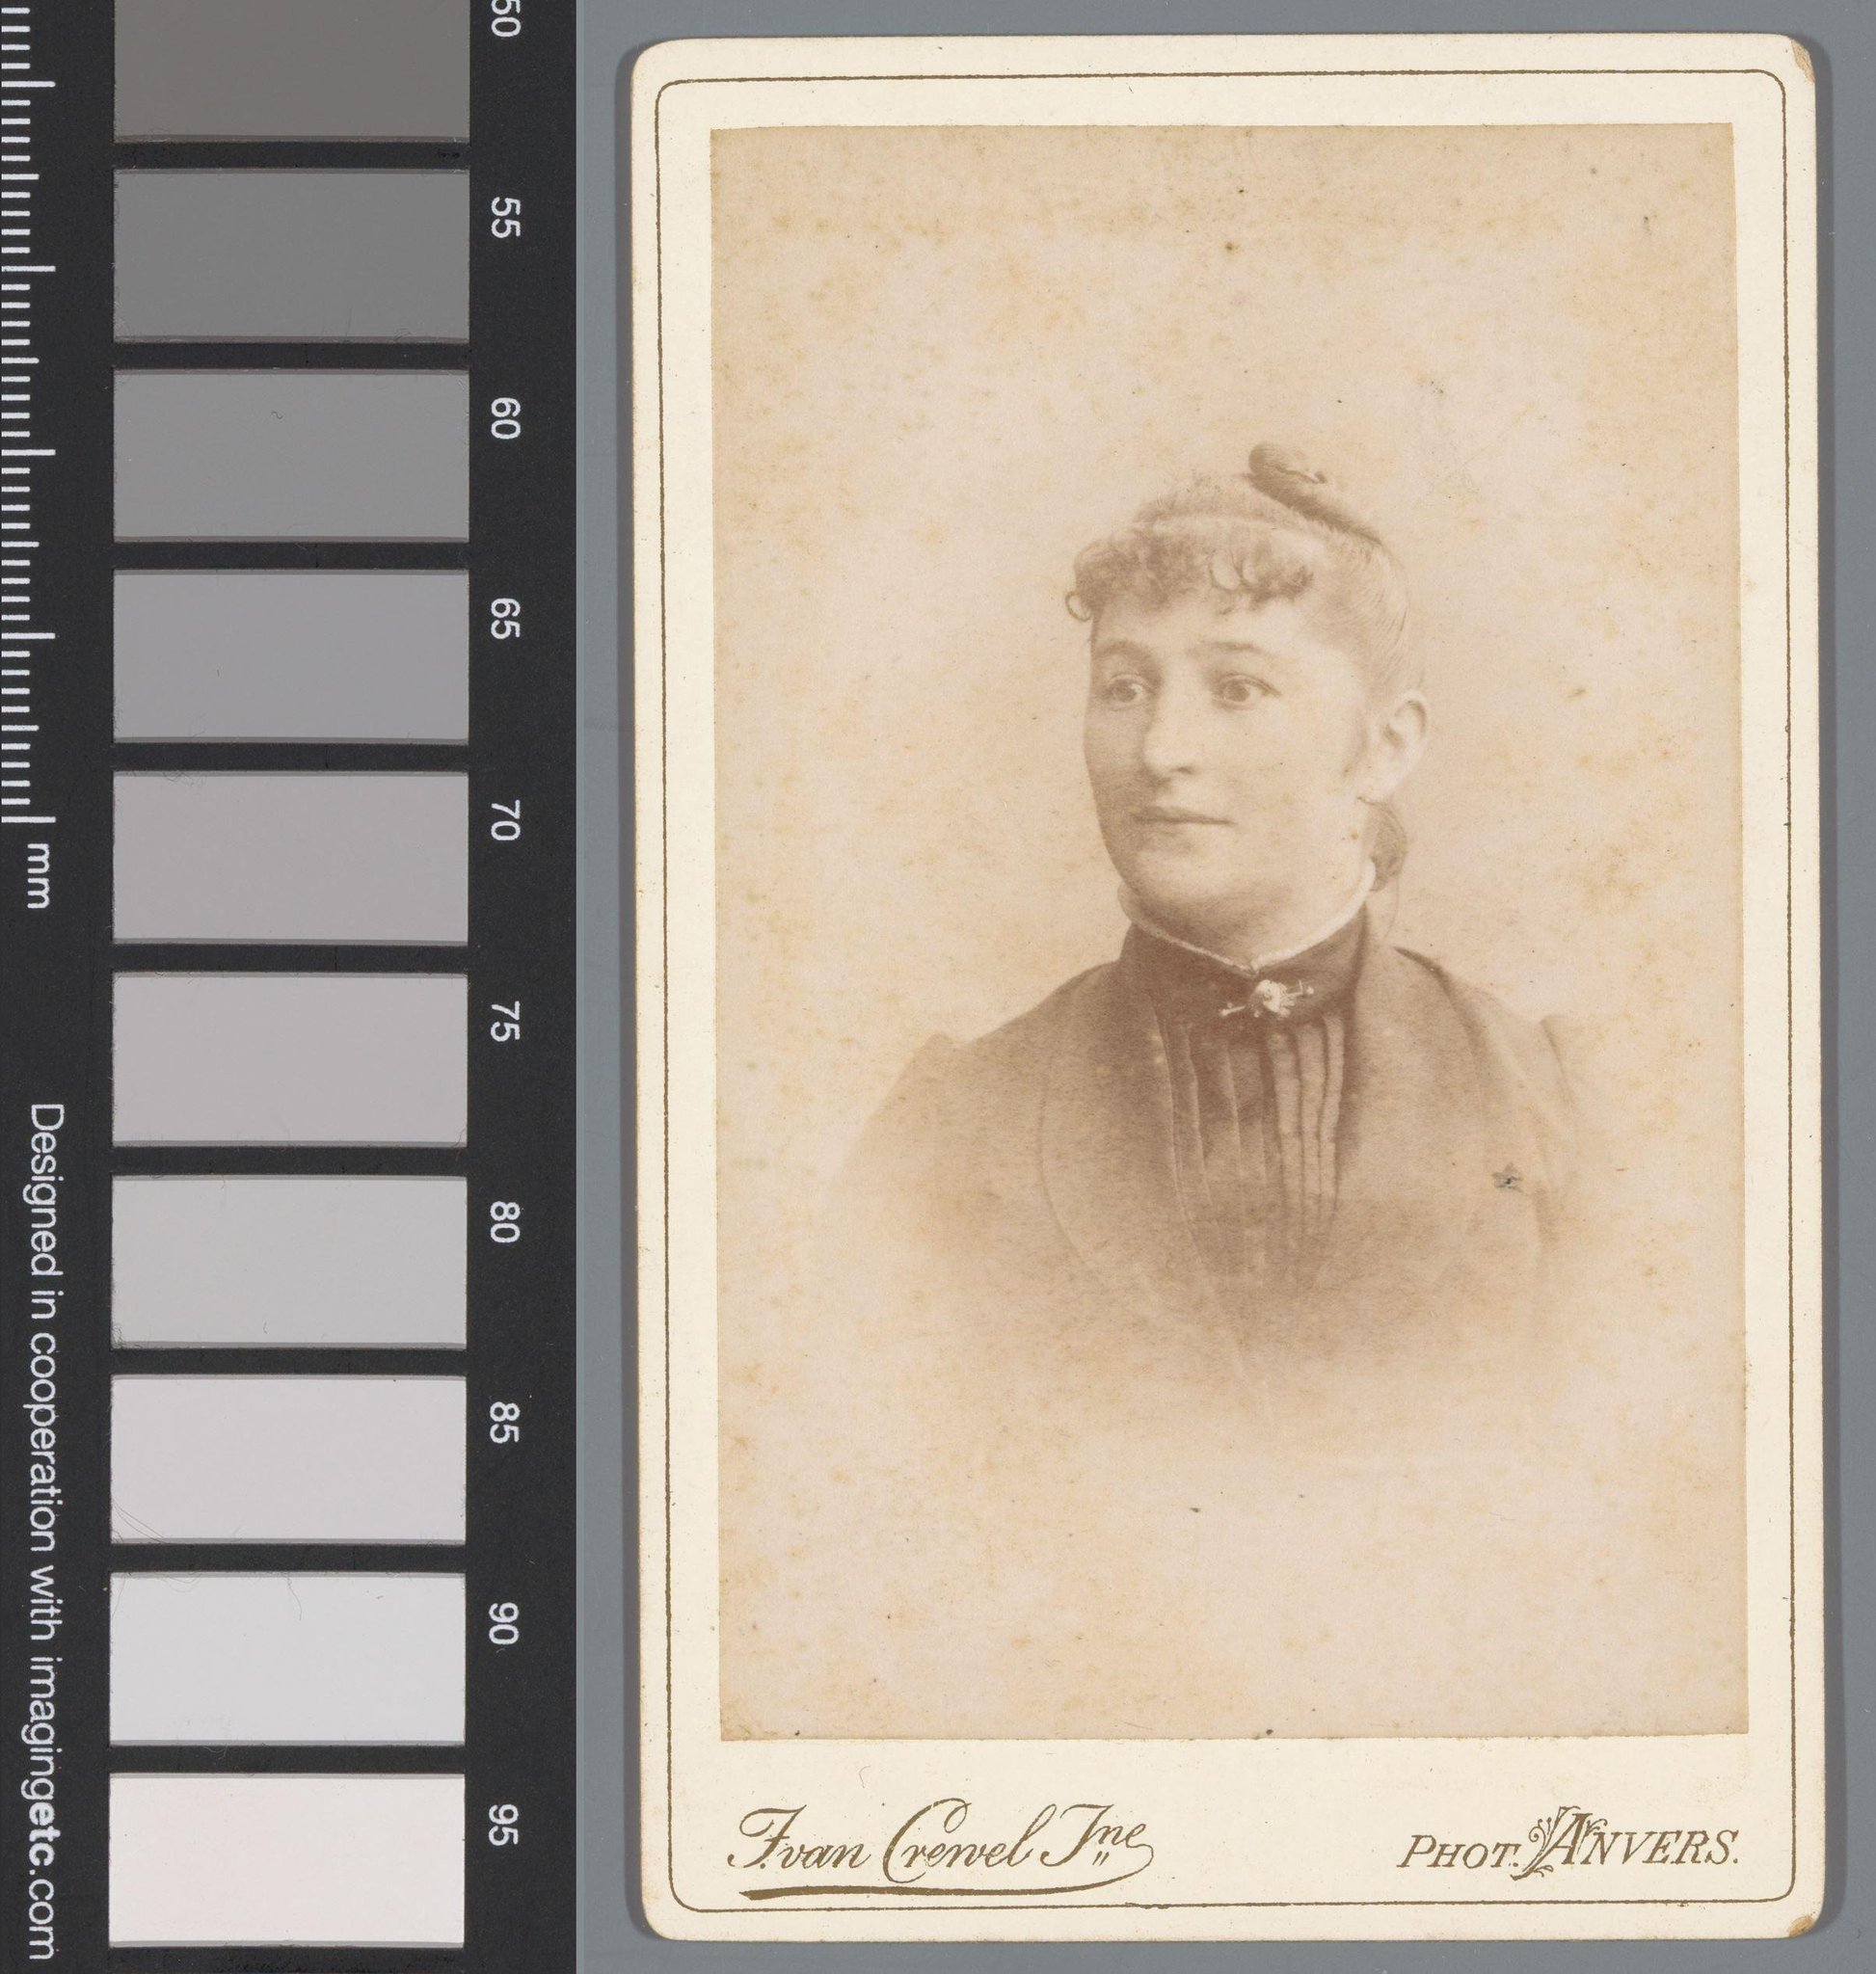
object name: carte de visite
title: Portret van een onbekende vrouw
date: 1885-1900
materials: cardboard, paper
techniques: albumen print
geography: antwerp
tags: adult woman, anonymous historical person portrayed, antwerp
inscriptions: inscription: ‘Brévet d'Invention/ Médaille d'argent à l'Exposition Rubens 1881,/ obtenue pour le procédé instantané./ Médaille de bronze à l'Exposition Universelle d'Anvers 1885./ J. van Crewel Jeune/ Photographe bréveté/ 48. rue du Pélican 48,/ en face de la Gare/ Anvers/ Galerie de pose dans le Jardin./ W. Herrmann & Co., Berlin.’, inscription: ‘J. van Crewel Jne Phot. Anvers.’